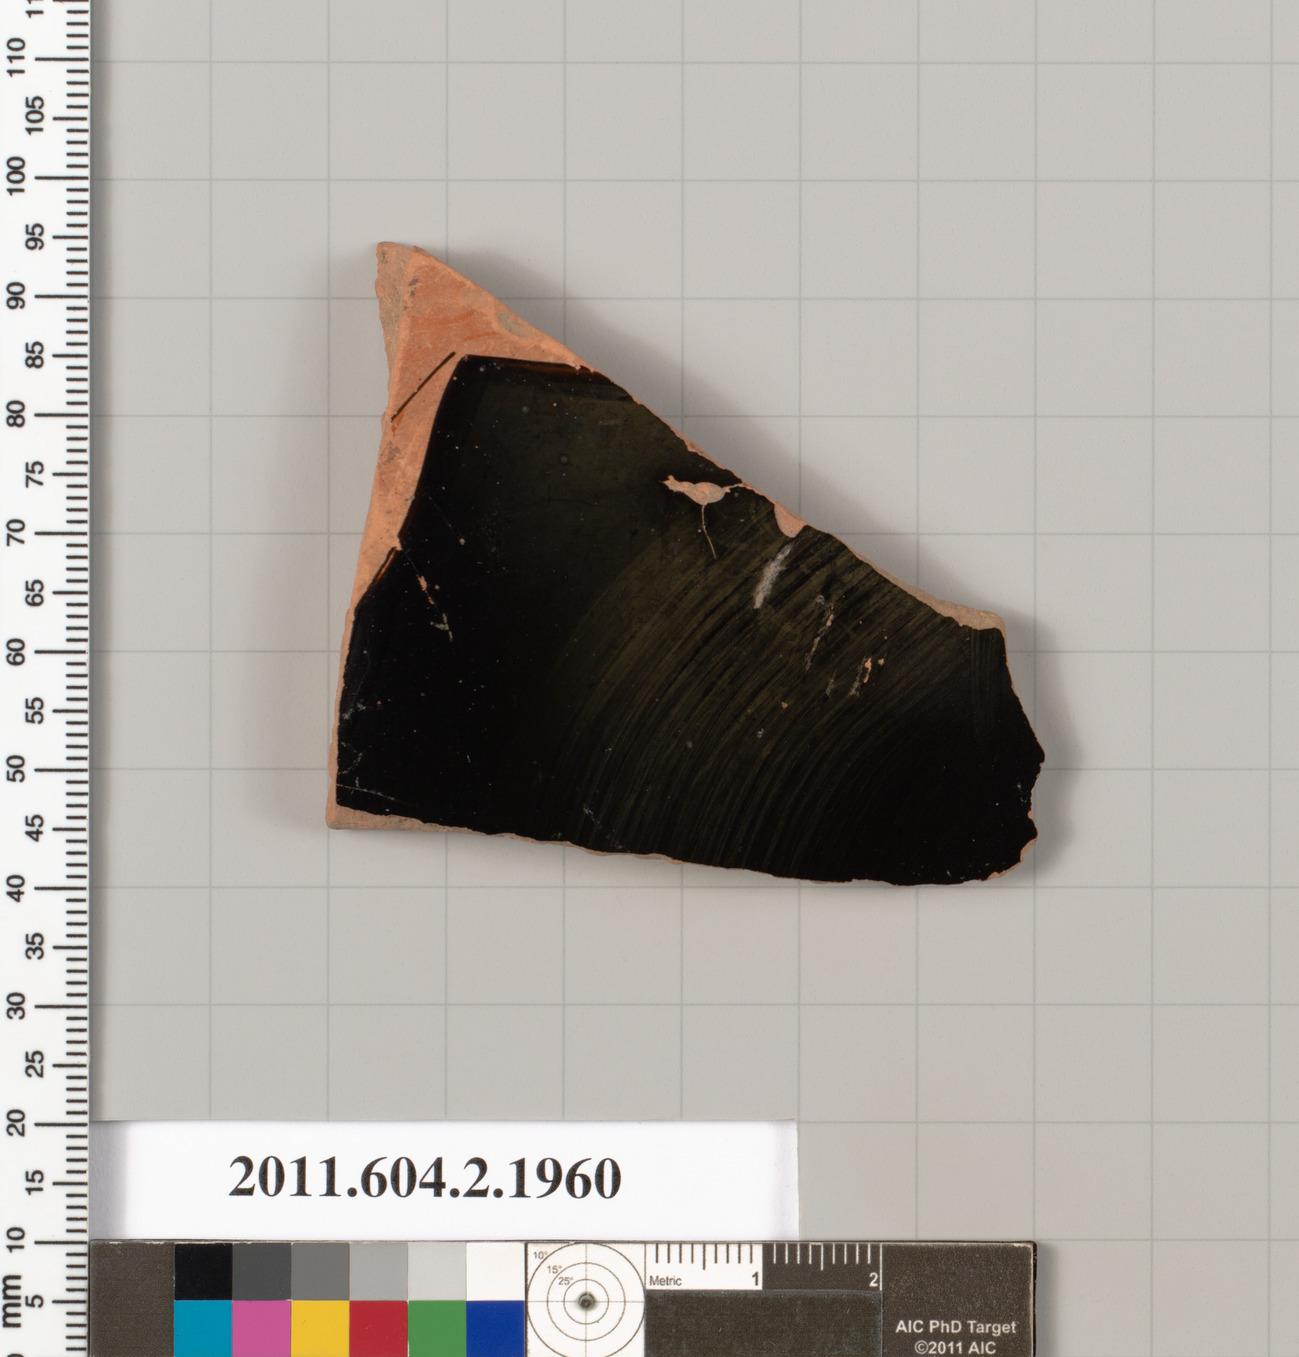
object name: neck amphora fragment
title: Terracotta fragment of a neck-amphora (jar)?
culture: greek, attic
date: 475-451 BCE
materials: terracotta